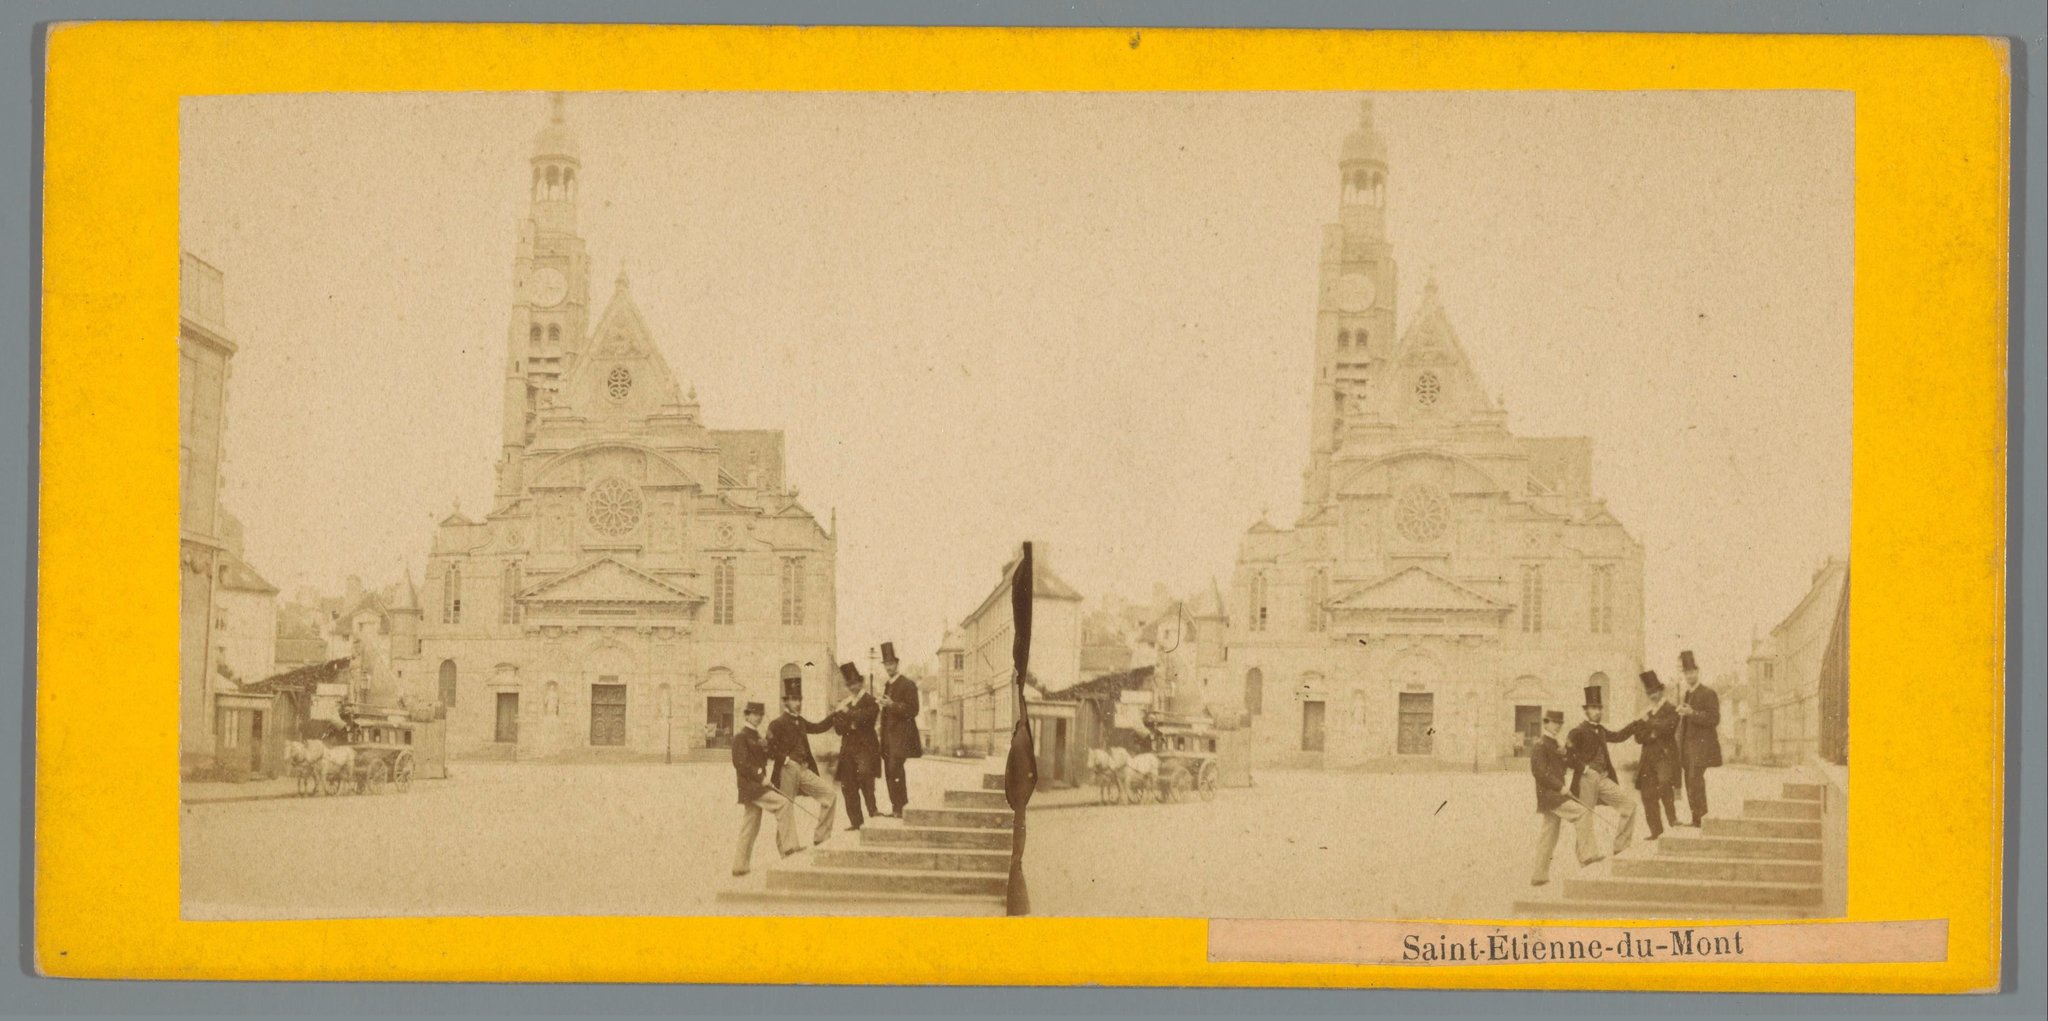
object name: stereograph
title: Gezicht op de Église Saint-Étienne-du-Mont in Parijs en vier mannen op een trap ervoor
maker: Anonymous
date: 1850-1880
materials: cardboard, photographic support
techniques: albumen print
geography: paris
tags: church (exterior), front steps, head-gear: top hat